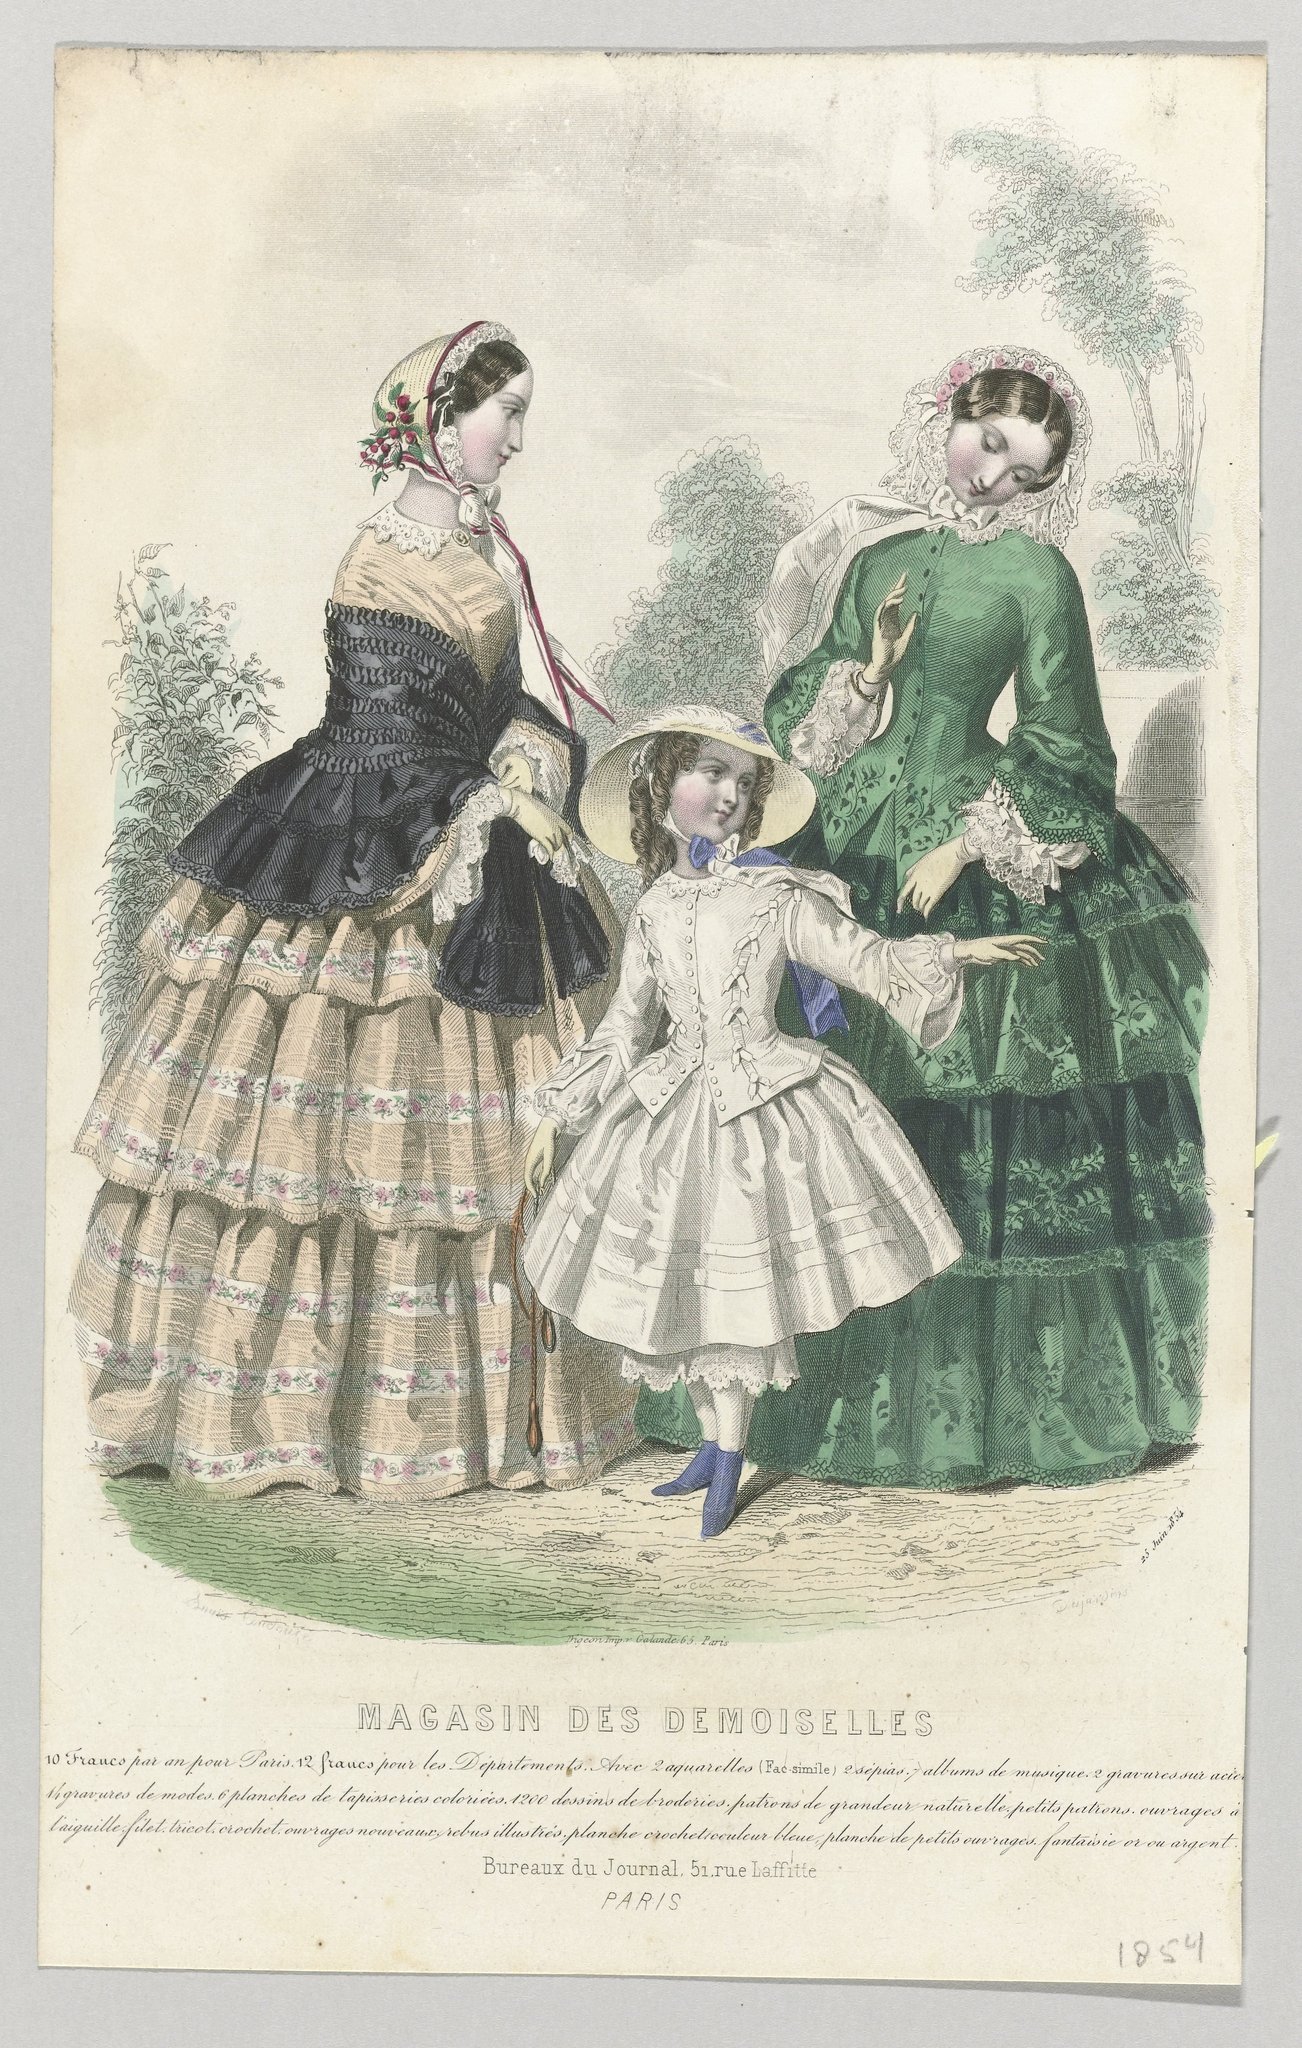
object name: fashion print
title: Magasin des Demoiselles, 25 Juin 1854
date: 1854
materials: paper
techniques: hand coloring, engraving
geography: paris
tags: handkerchief (+ women's clothes), brooch, agraffe, clasp (+ women's clothes), clothes, costume (+ girls' clothes), head-gear: cap (+ women's clothes), fashion plates, gloves, mittens, etc. (+ women's clothes), jumping-rope games, neck-gear ~ clothing (+ women's clothes), bracelet, wristlet (+ women's clothes)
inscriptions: address: ‘Bureaux du Journal, 51, rue Laffitte. / Paris’, title: ‘Magasin des Demoiselles’, caption: ‘10 Francs par an pour Paris 12 francs pour les Départements. Avec 2 Aquarelles (Fac-simile) 2 sepia, 7 albums de musique, 2 gravures sur acier, 14 gravures de modes, 6 planches de tapisseries coloriées, 1200 dessins de broderies, patrons de grandeur naturelle, petits patrons, ouvrages à l'aiguille, filet, tricot, crochet ouvrages nouveaux, rébus illustrés. planches crochet, couleur bleue: planche de petits ouvrages. fantaisie or ou argent.’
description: Twee vrouwen en een meisje met springtouw in de hand, staande in een tuin. Links: hooggesloten japon met wijde rok met bloem- en strepenmotief. Rechts: donkergroene japon met bladmotief. Wijd uitlopende mouwen en geplooide ondermouwen. Onder de voorstelling enkele regels informatie over het modetijdschrift. Prent uit het modetijdschrift Magasin des Demoiselles (1844-1896).